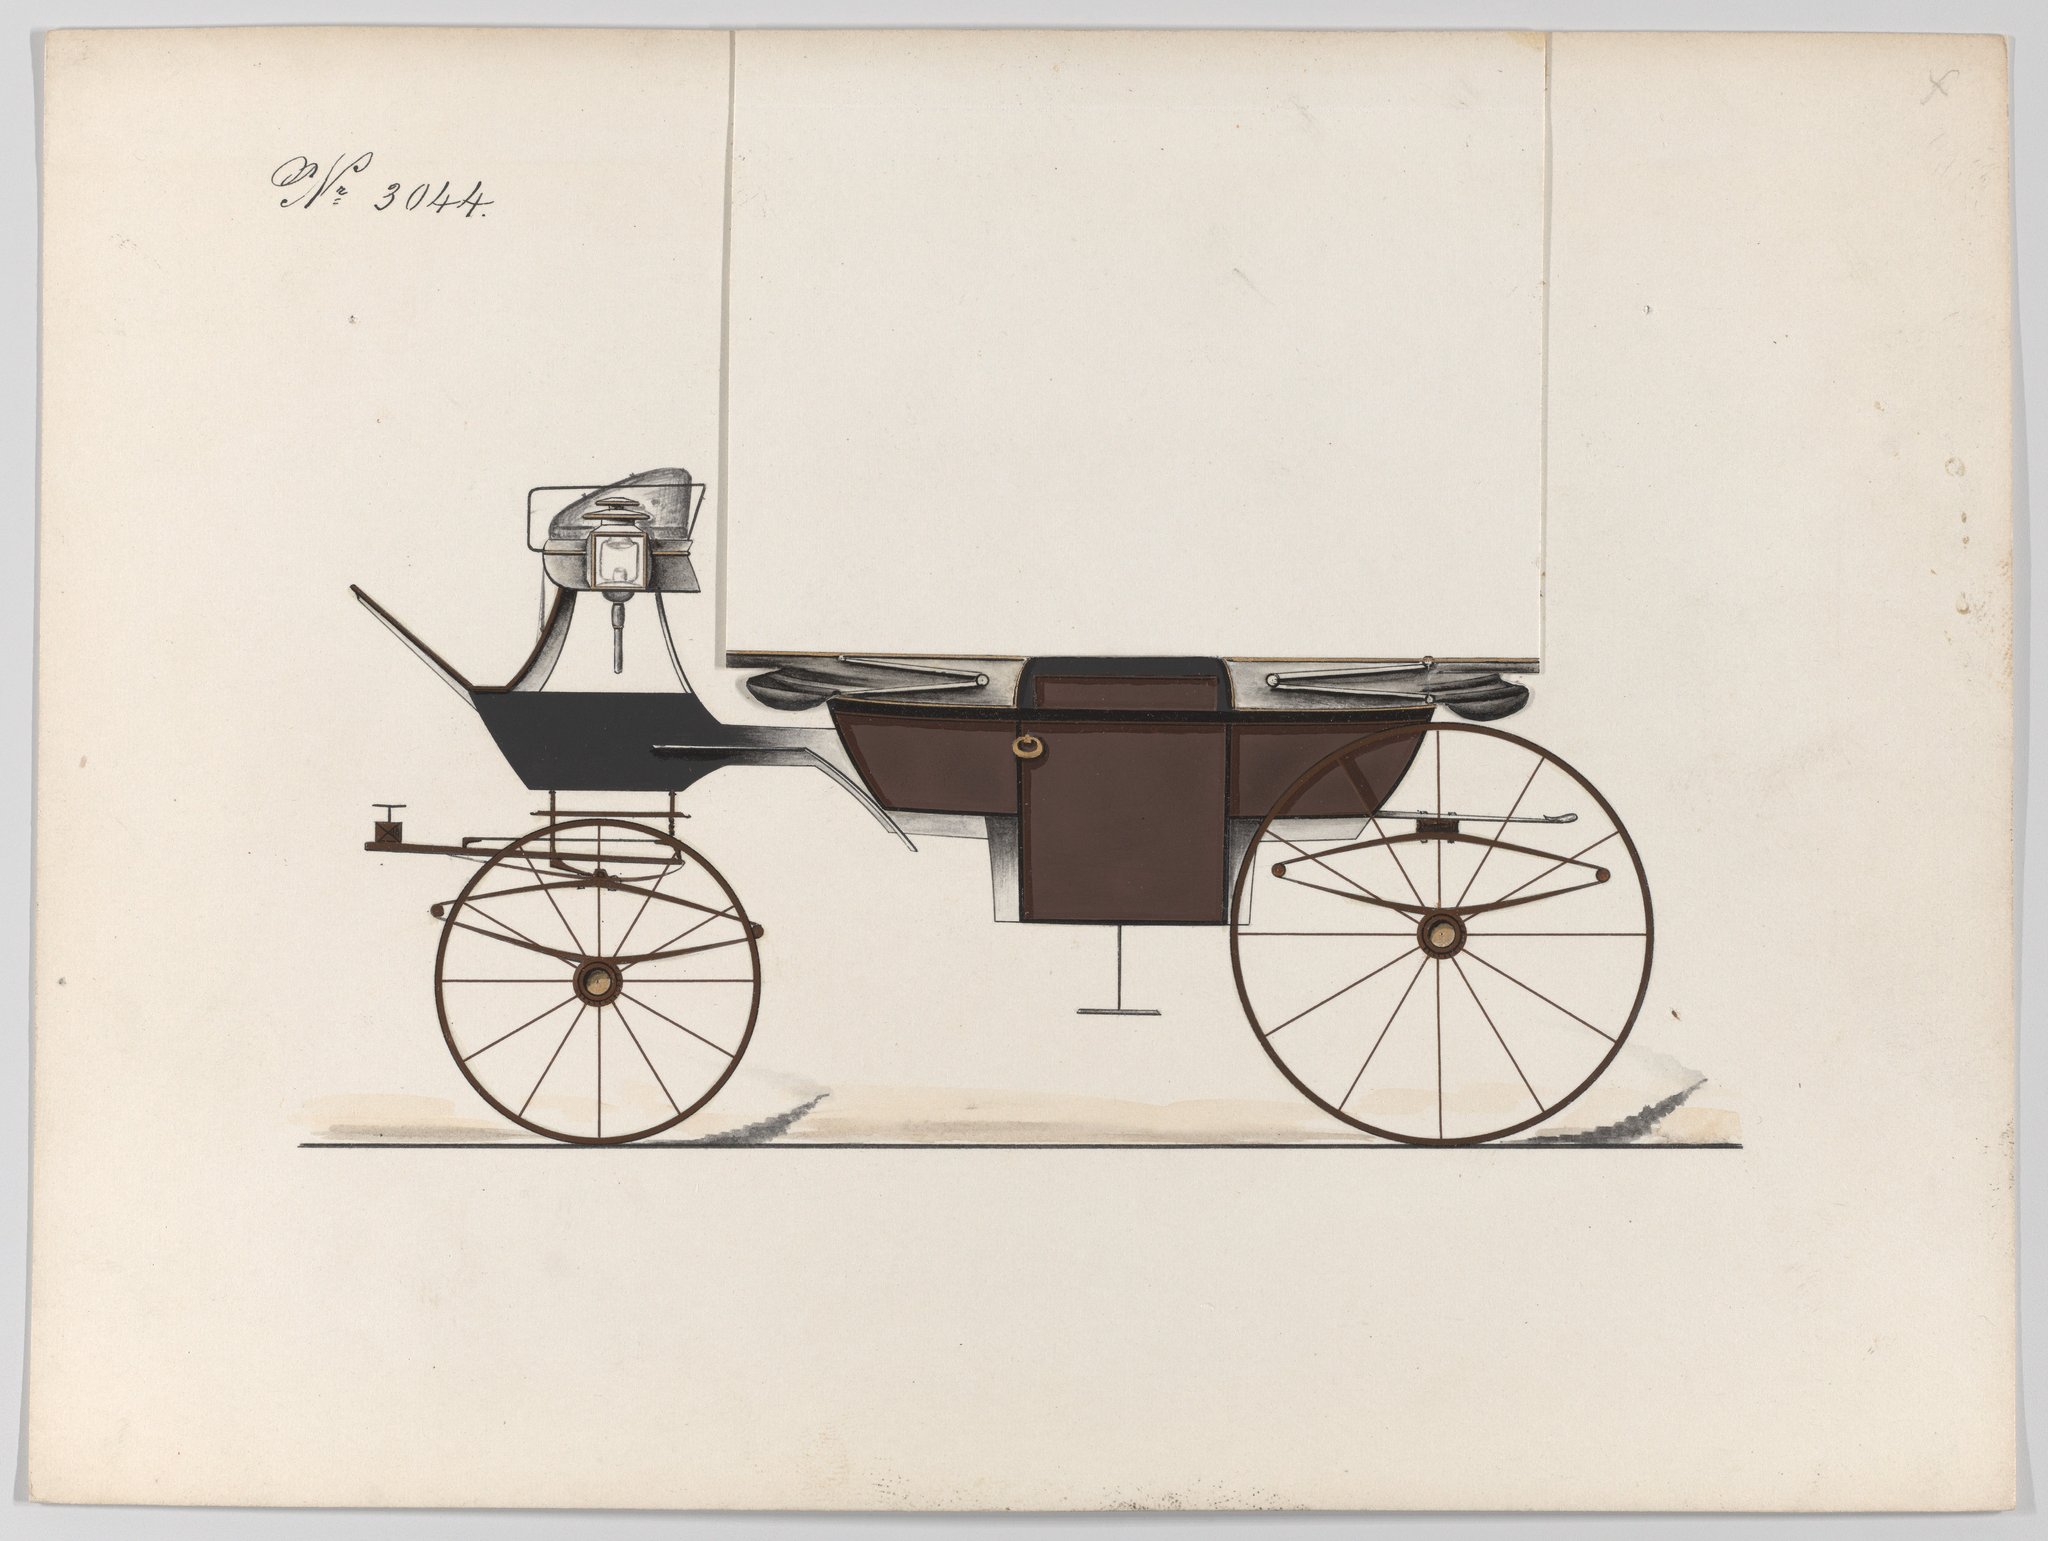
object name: drawing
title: Design for Landau, No. 3044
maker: brewster & co.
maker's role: manufacturer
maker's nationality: american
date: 1874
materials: gouache, gum arabic, ink, watercolor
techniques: pen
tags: carriages